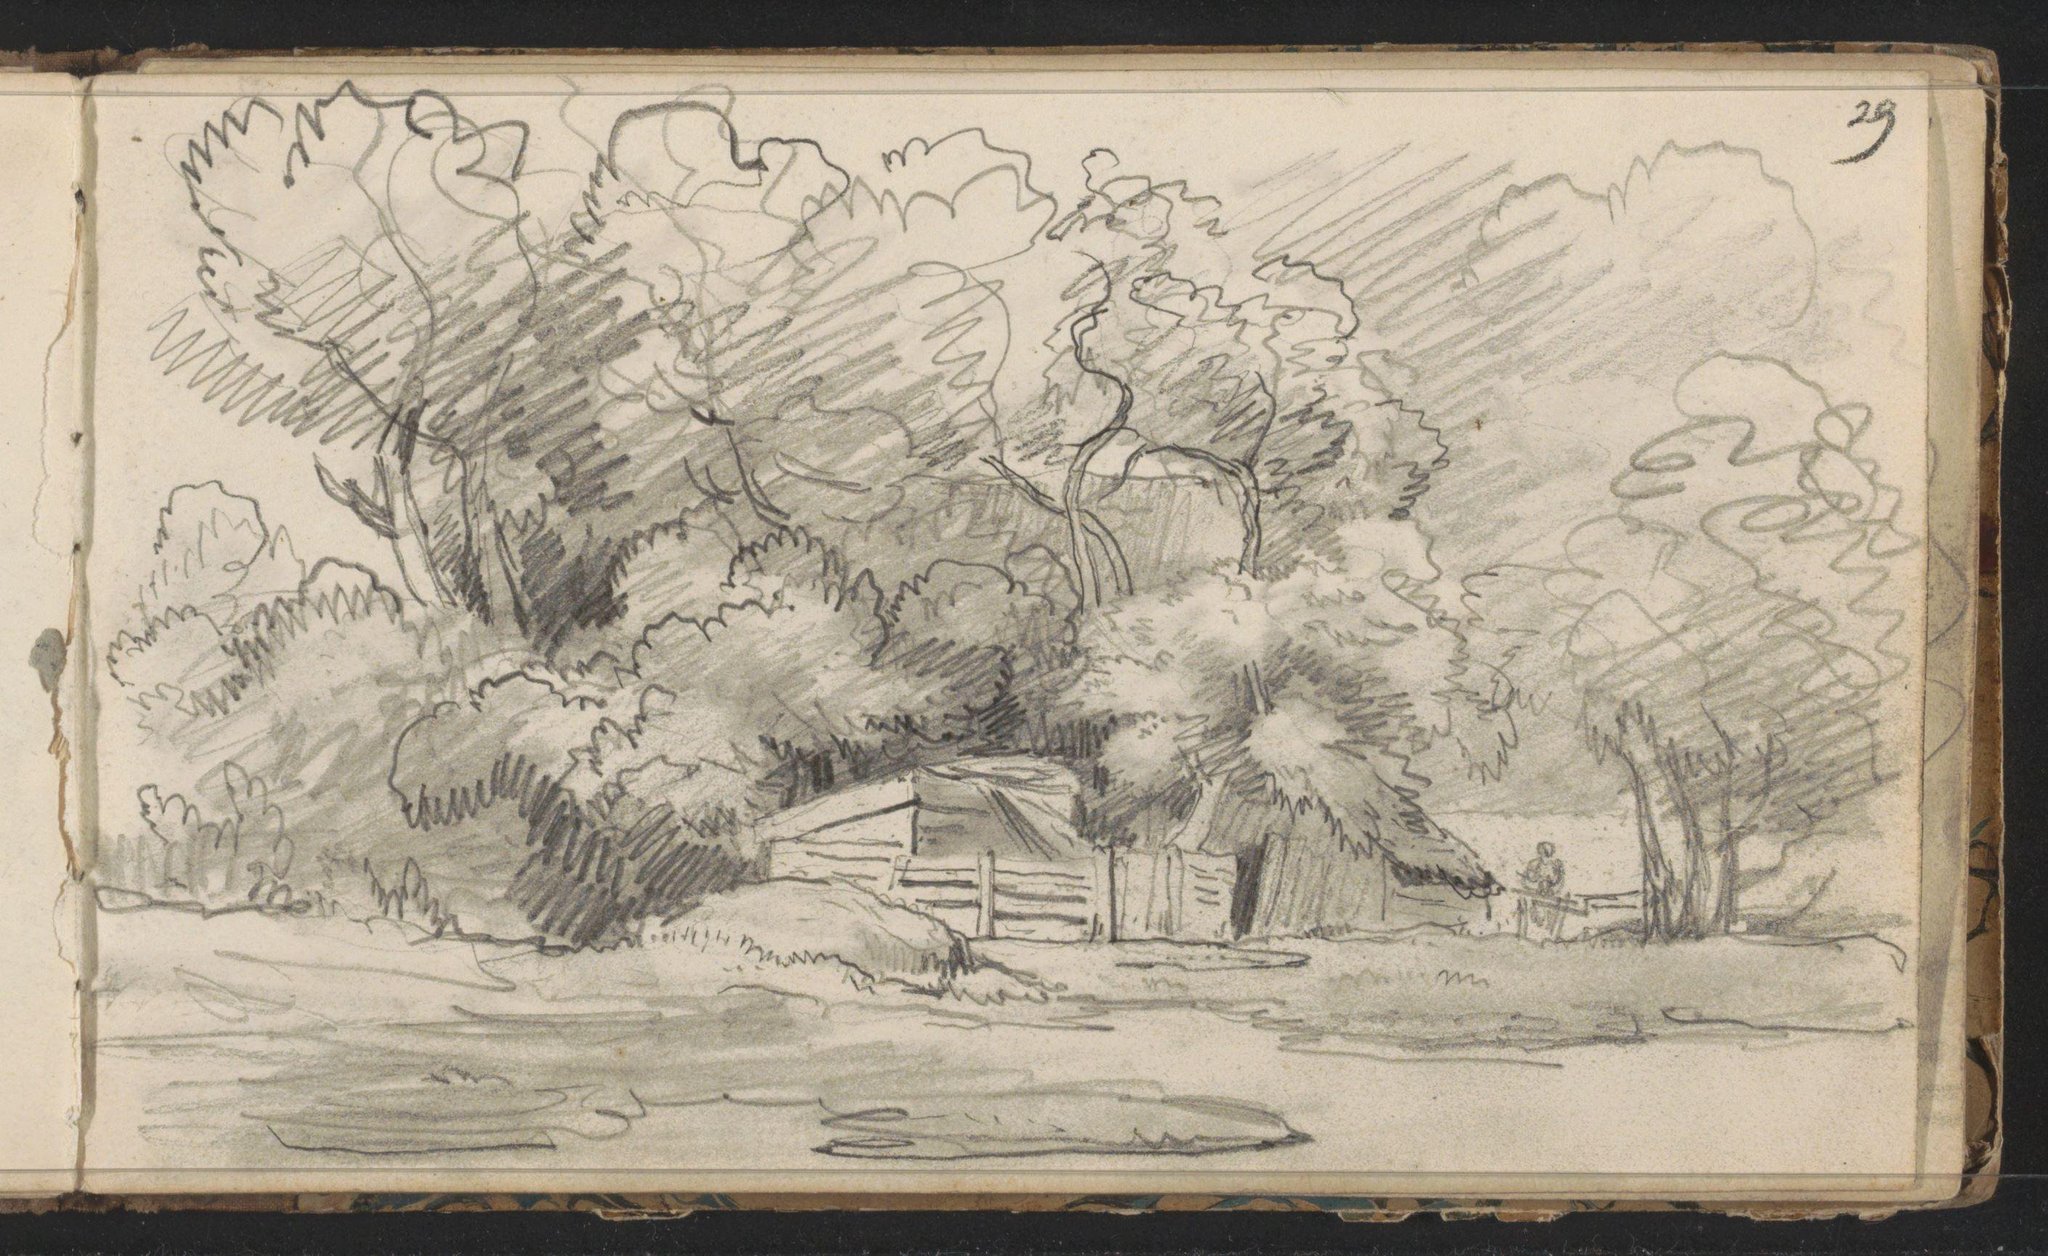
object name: sketchbook leaf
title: Landschap met een figuur bij twee hutten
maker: arnoldus johannes eymer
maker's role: draughtsman, print maker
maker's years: 1803-1863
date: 1803-1818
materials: paper, pencil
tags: hut, cabin, lodge, landscapes (+ landscape with figures, staffage)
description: Bladzijde 29 uit een schetsboek met 74 bladzijden.